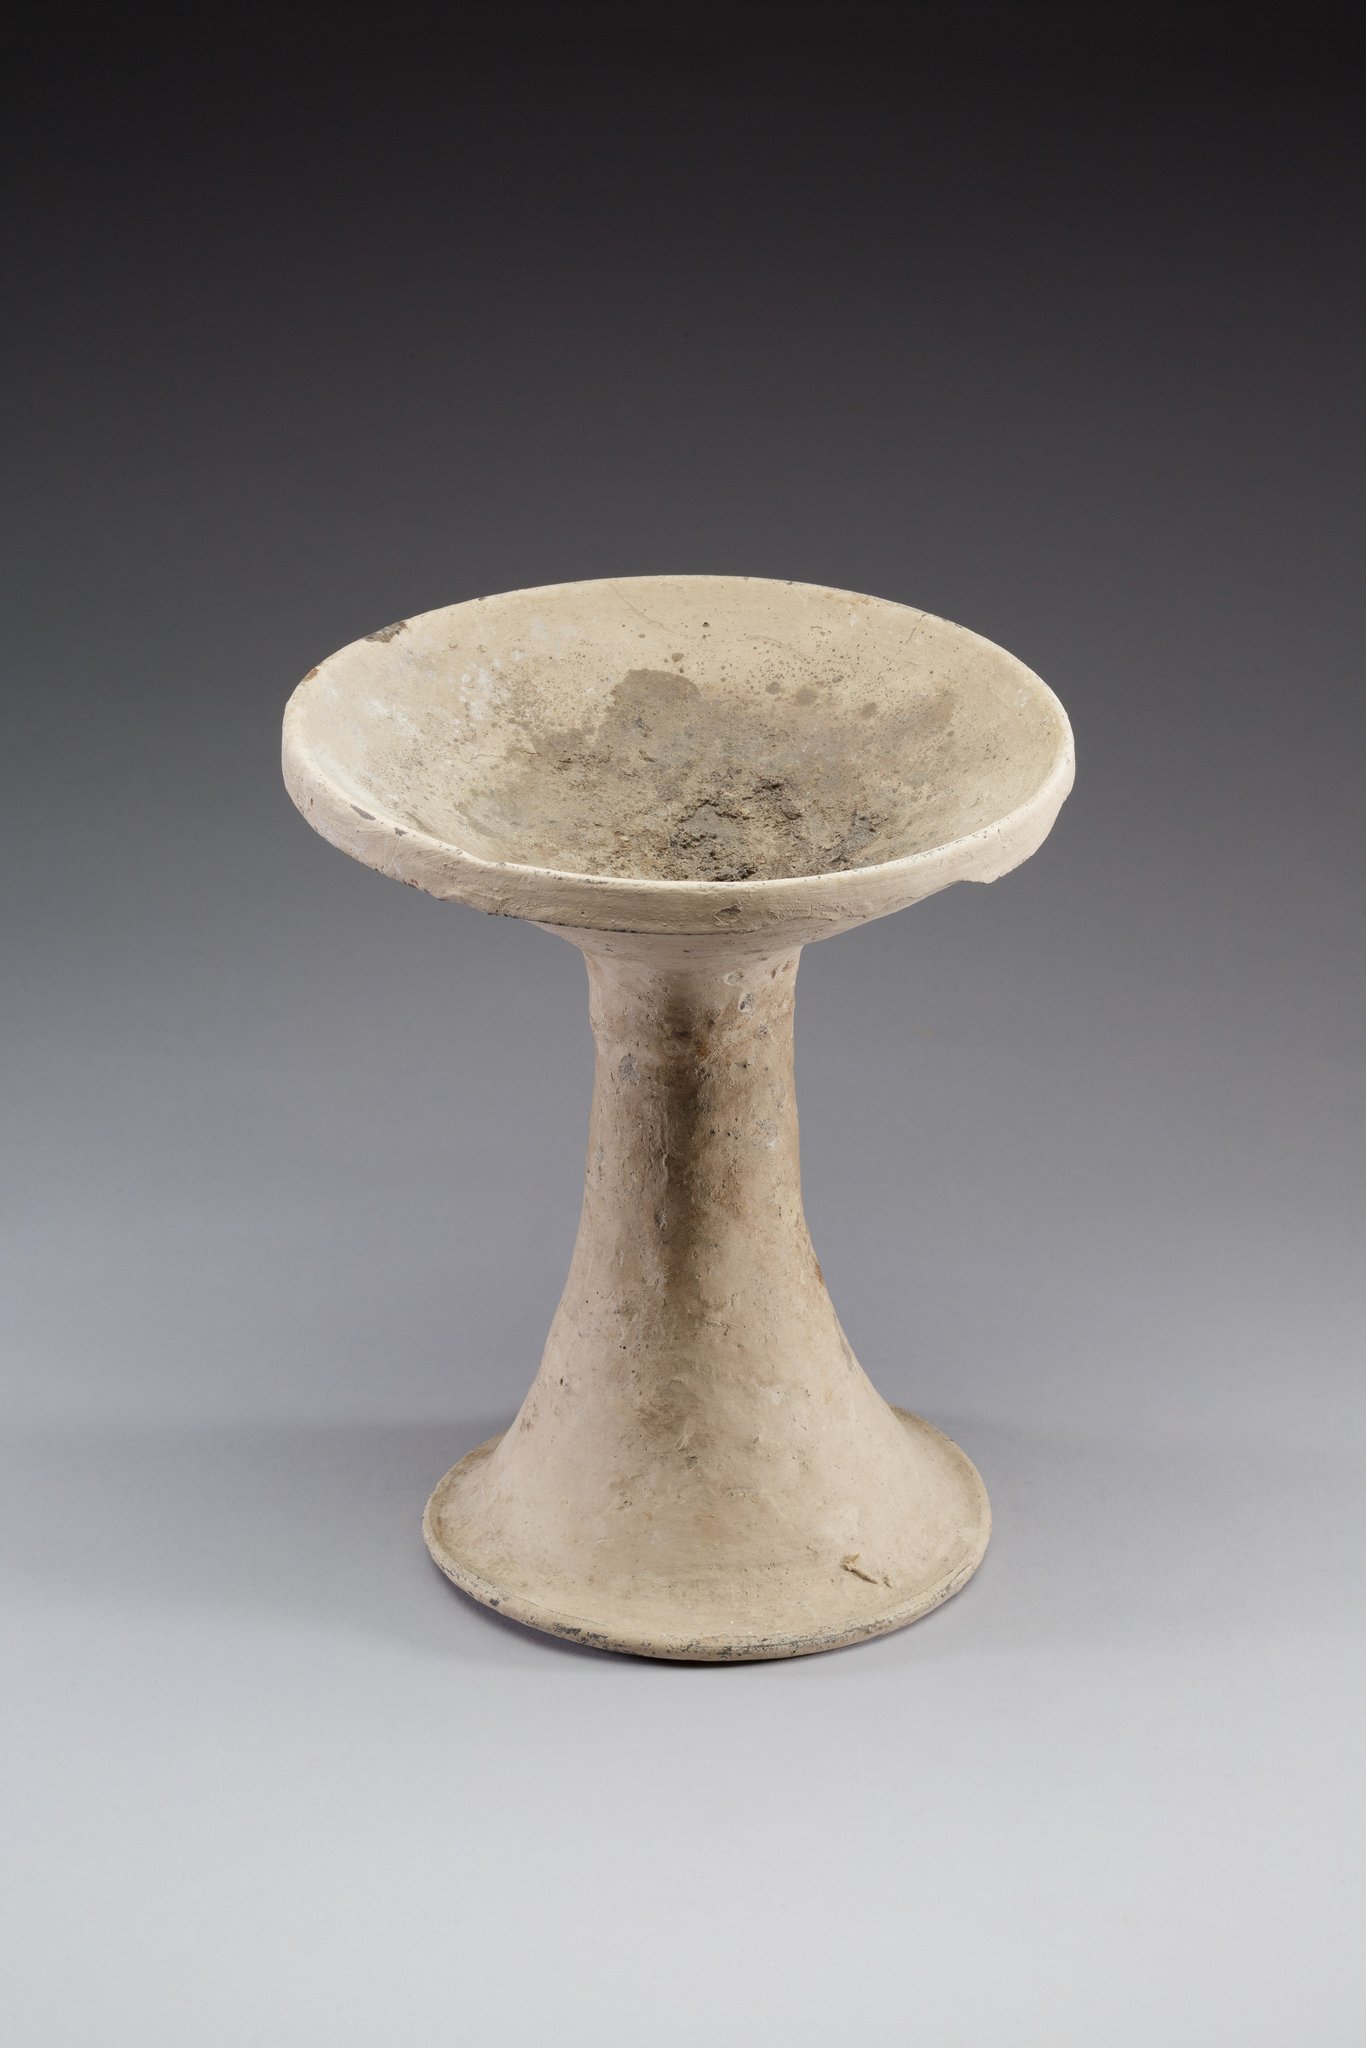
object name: brazier, marl, amenhotep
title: Brazier from the Burial of Amenhotep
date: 1479-1458 BCE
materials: pottery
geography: egypt